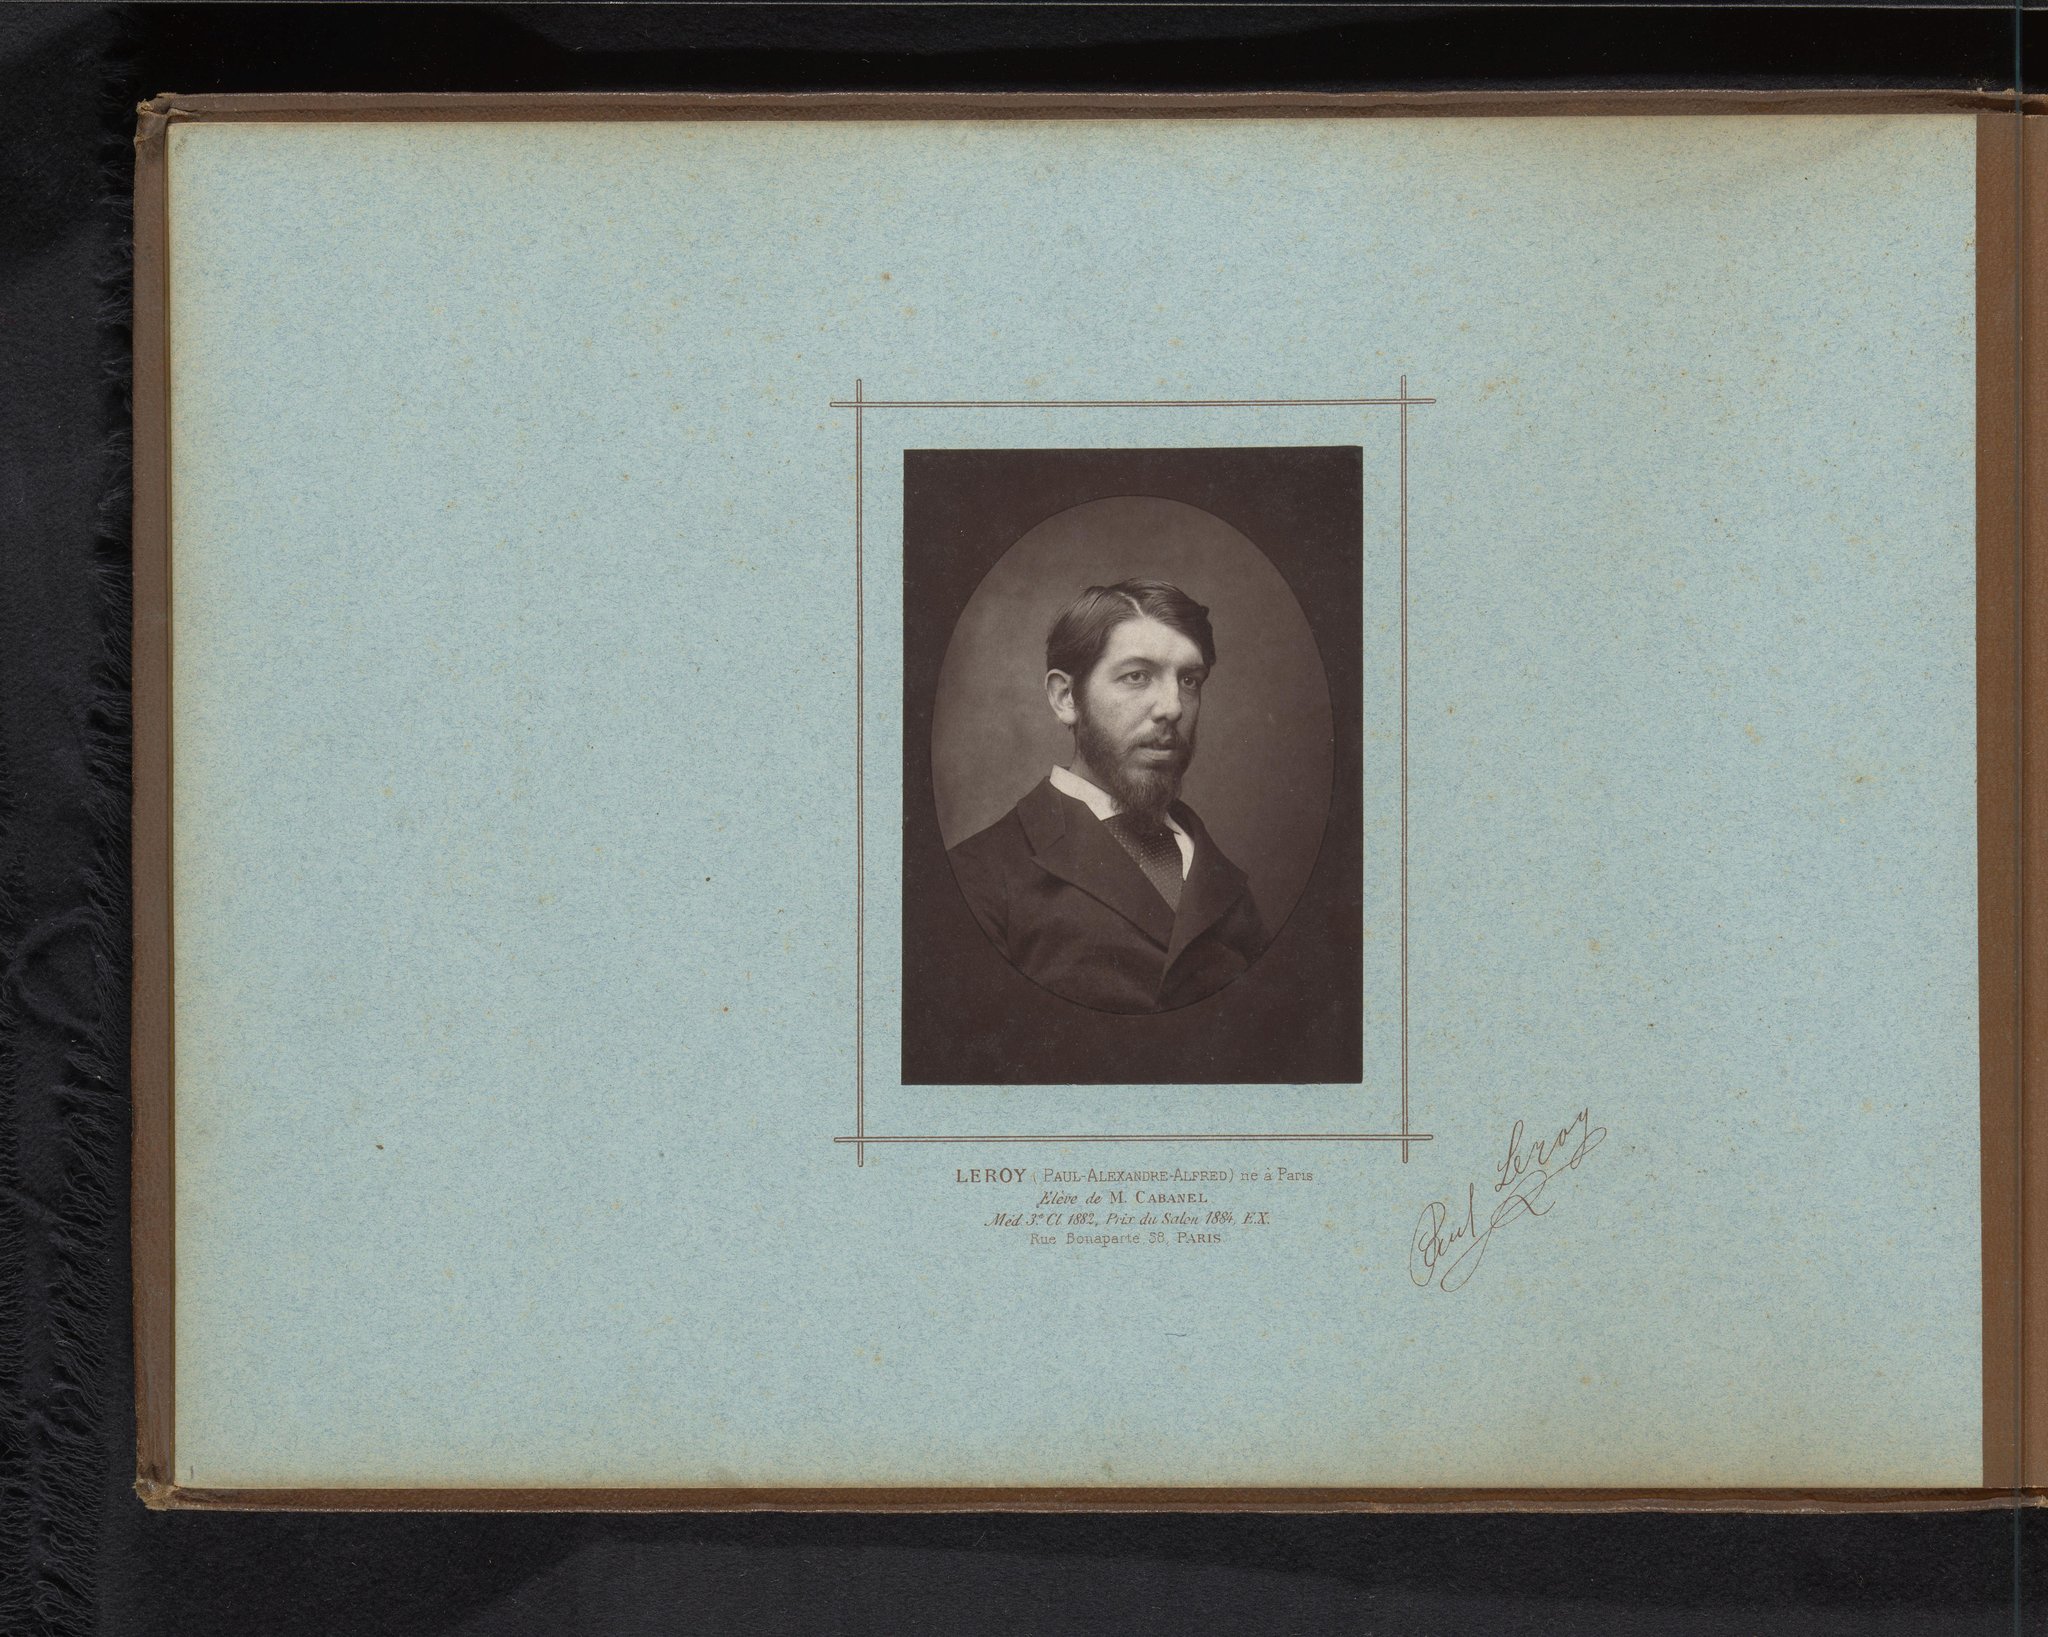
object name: photomechanical print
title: Portret van Paul Leroy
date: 1879-1884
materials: paper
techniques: woodburytype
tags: paris, paul alexandre alfred leroy, historical persons, portrait, self-portrait of painter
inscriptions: signature: ‘Paul Leroy’, inscription: ‘LEROY (Paul-Alexandre-Alfred) né à Paris/ Élève de M. Cabanel/ Med. 3e. Cl. 1882, Prix du Salon 1884, E.X./ Rue Bonaparte, 58, Paris’